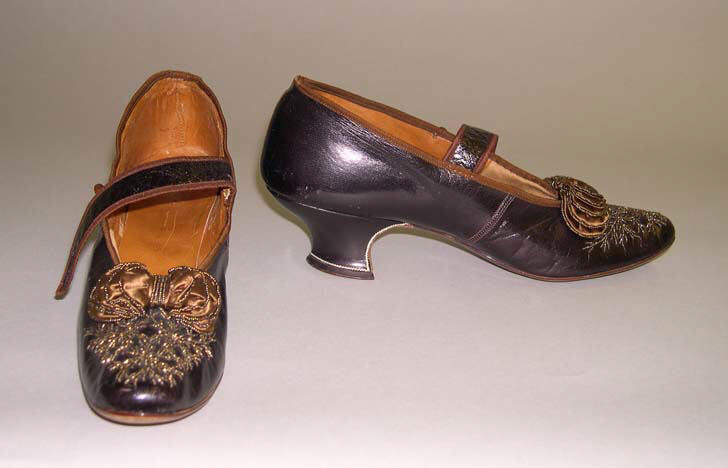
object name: shoe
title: Shoes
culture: american or european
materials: glass, leather, silk